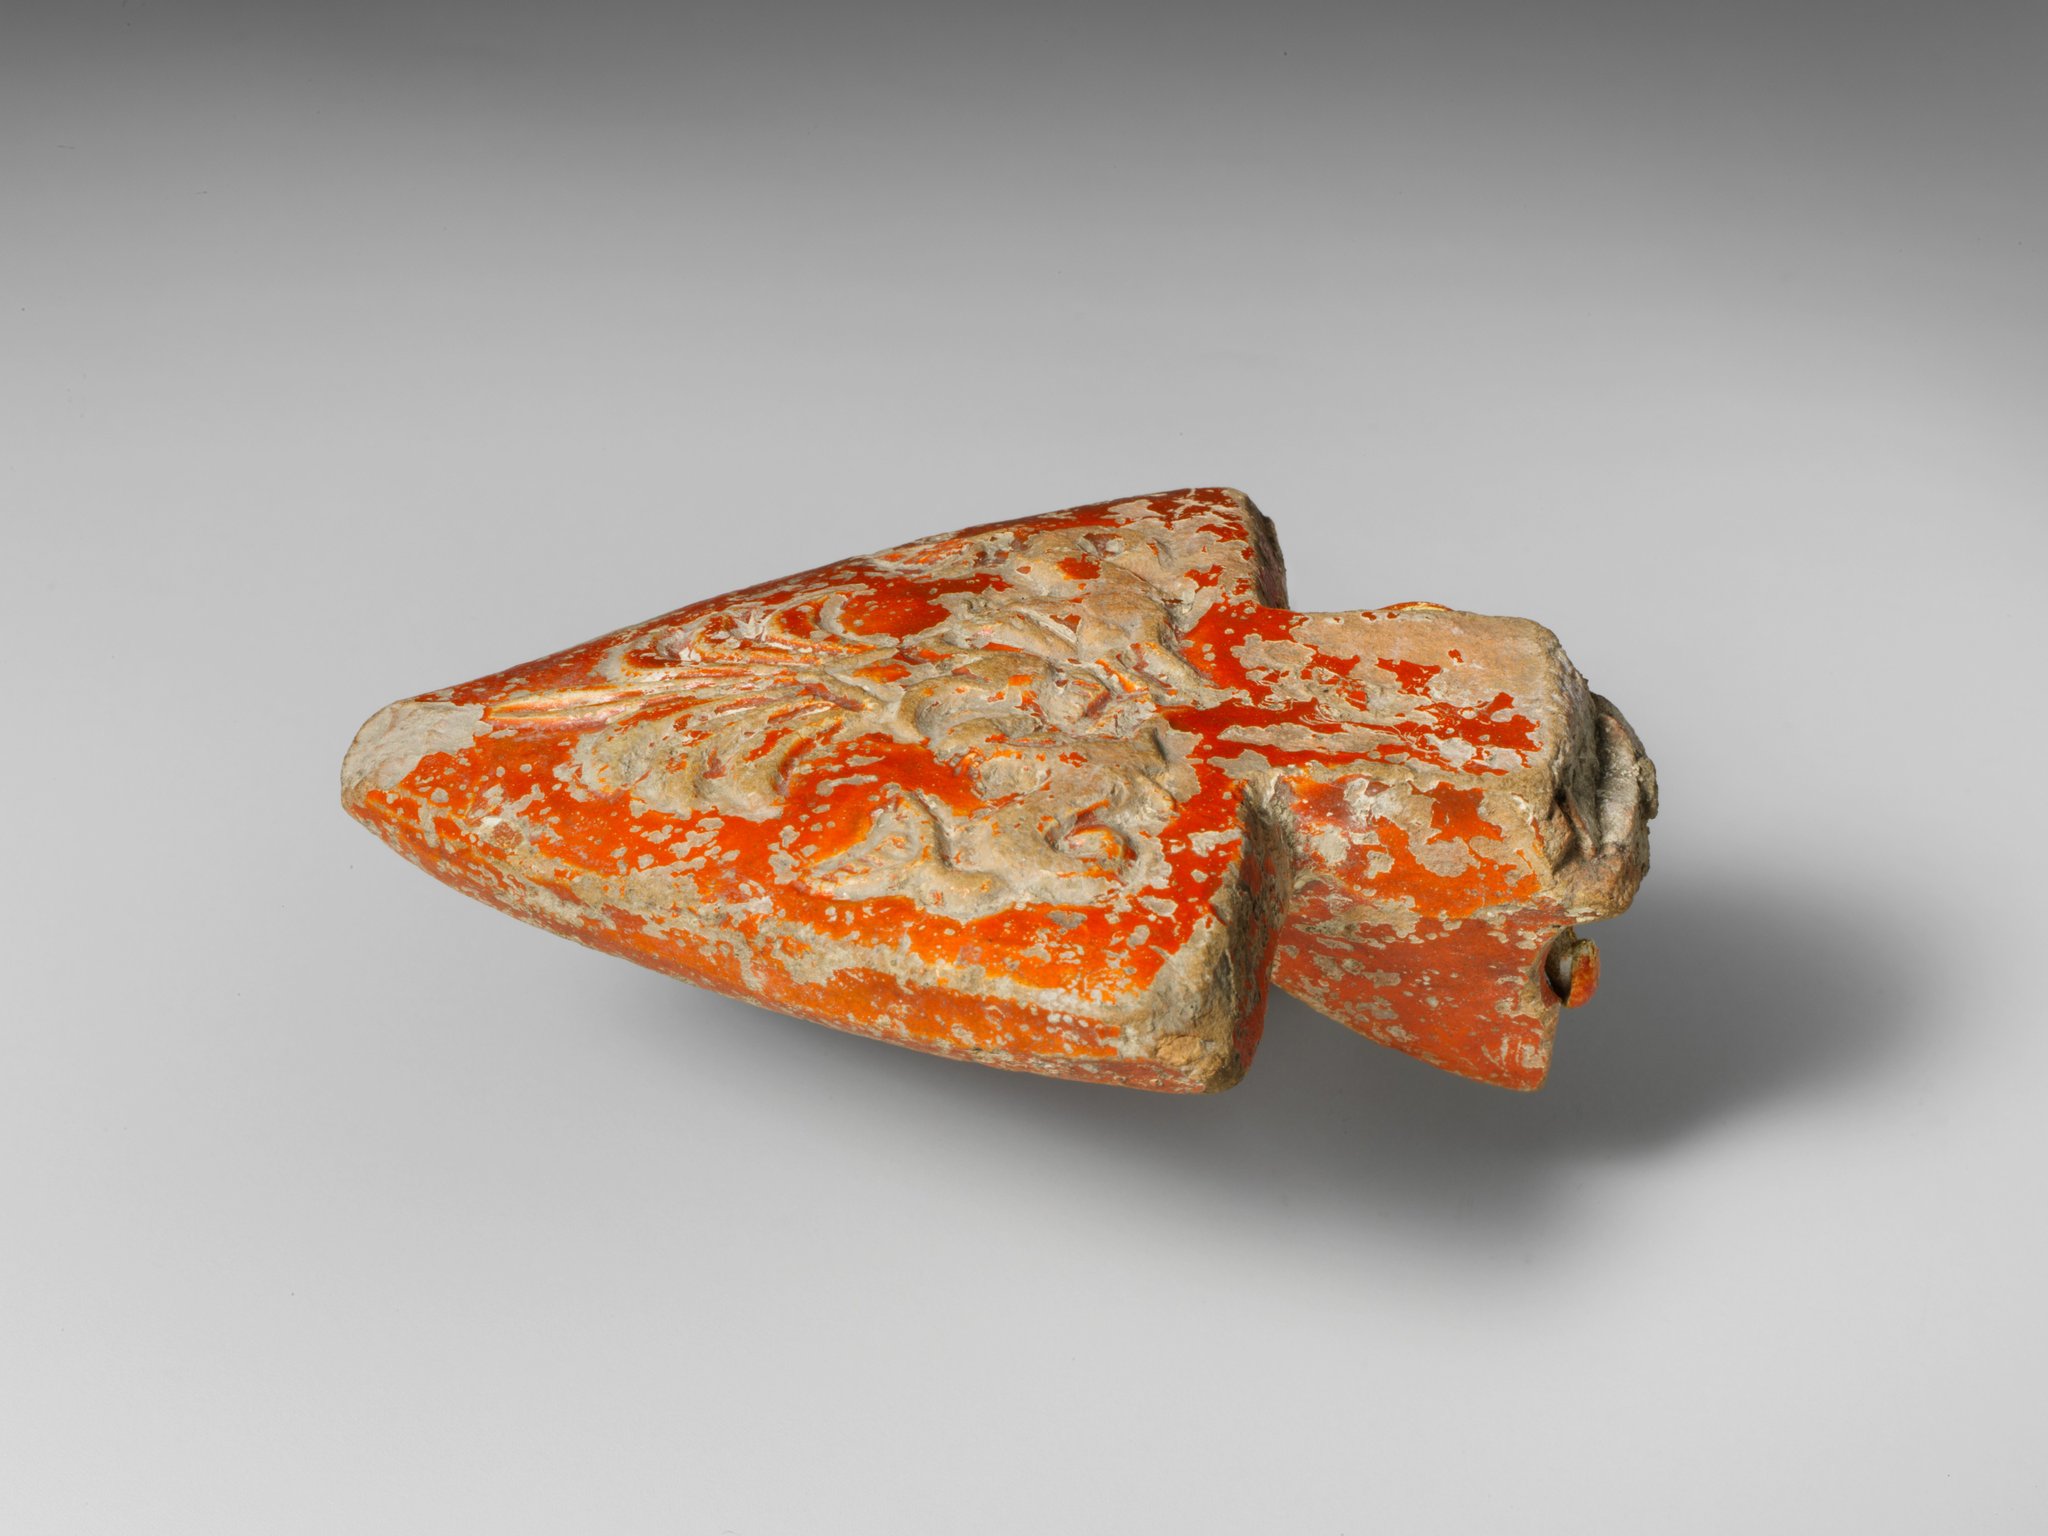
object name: lamp handle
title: Terracotta lamp handle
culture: roman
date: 25-75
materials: terracotta